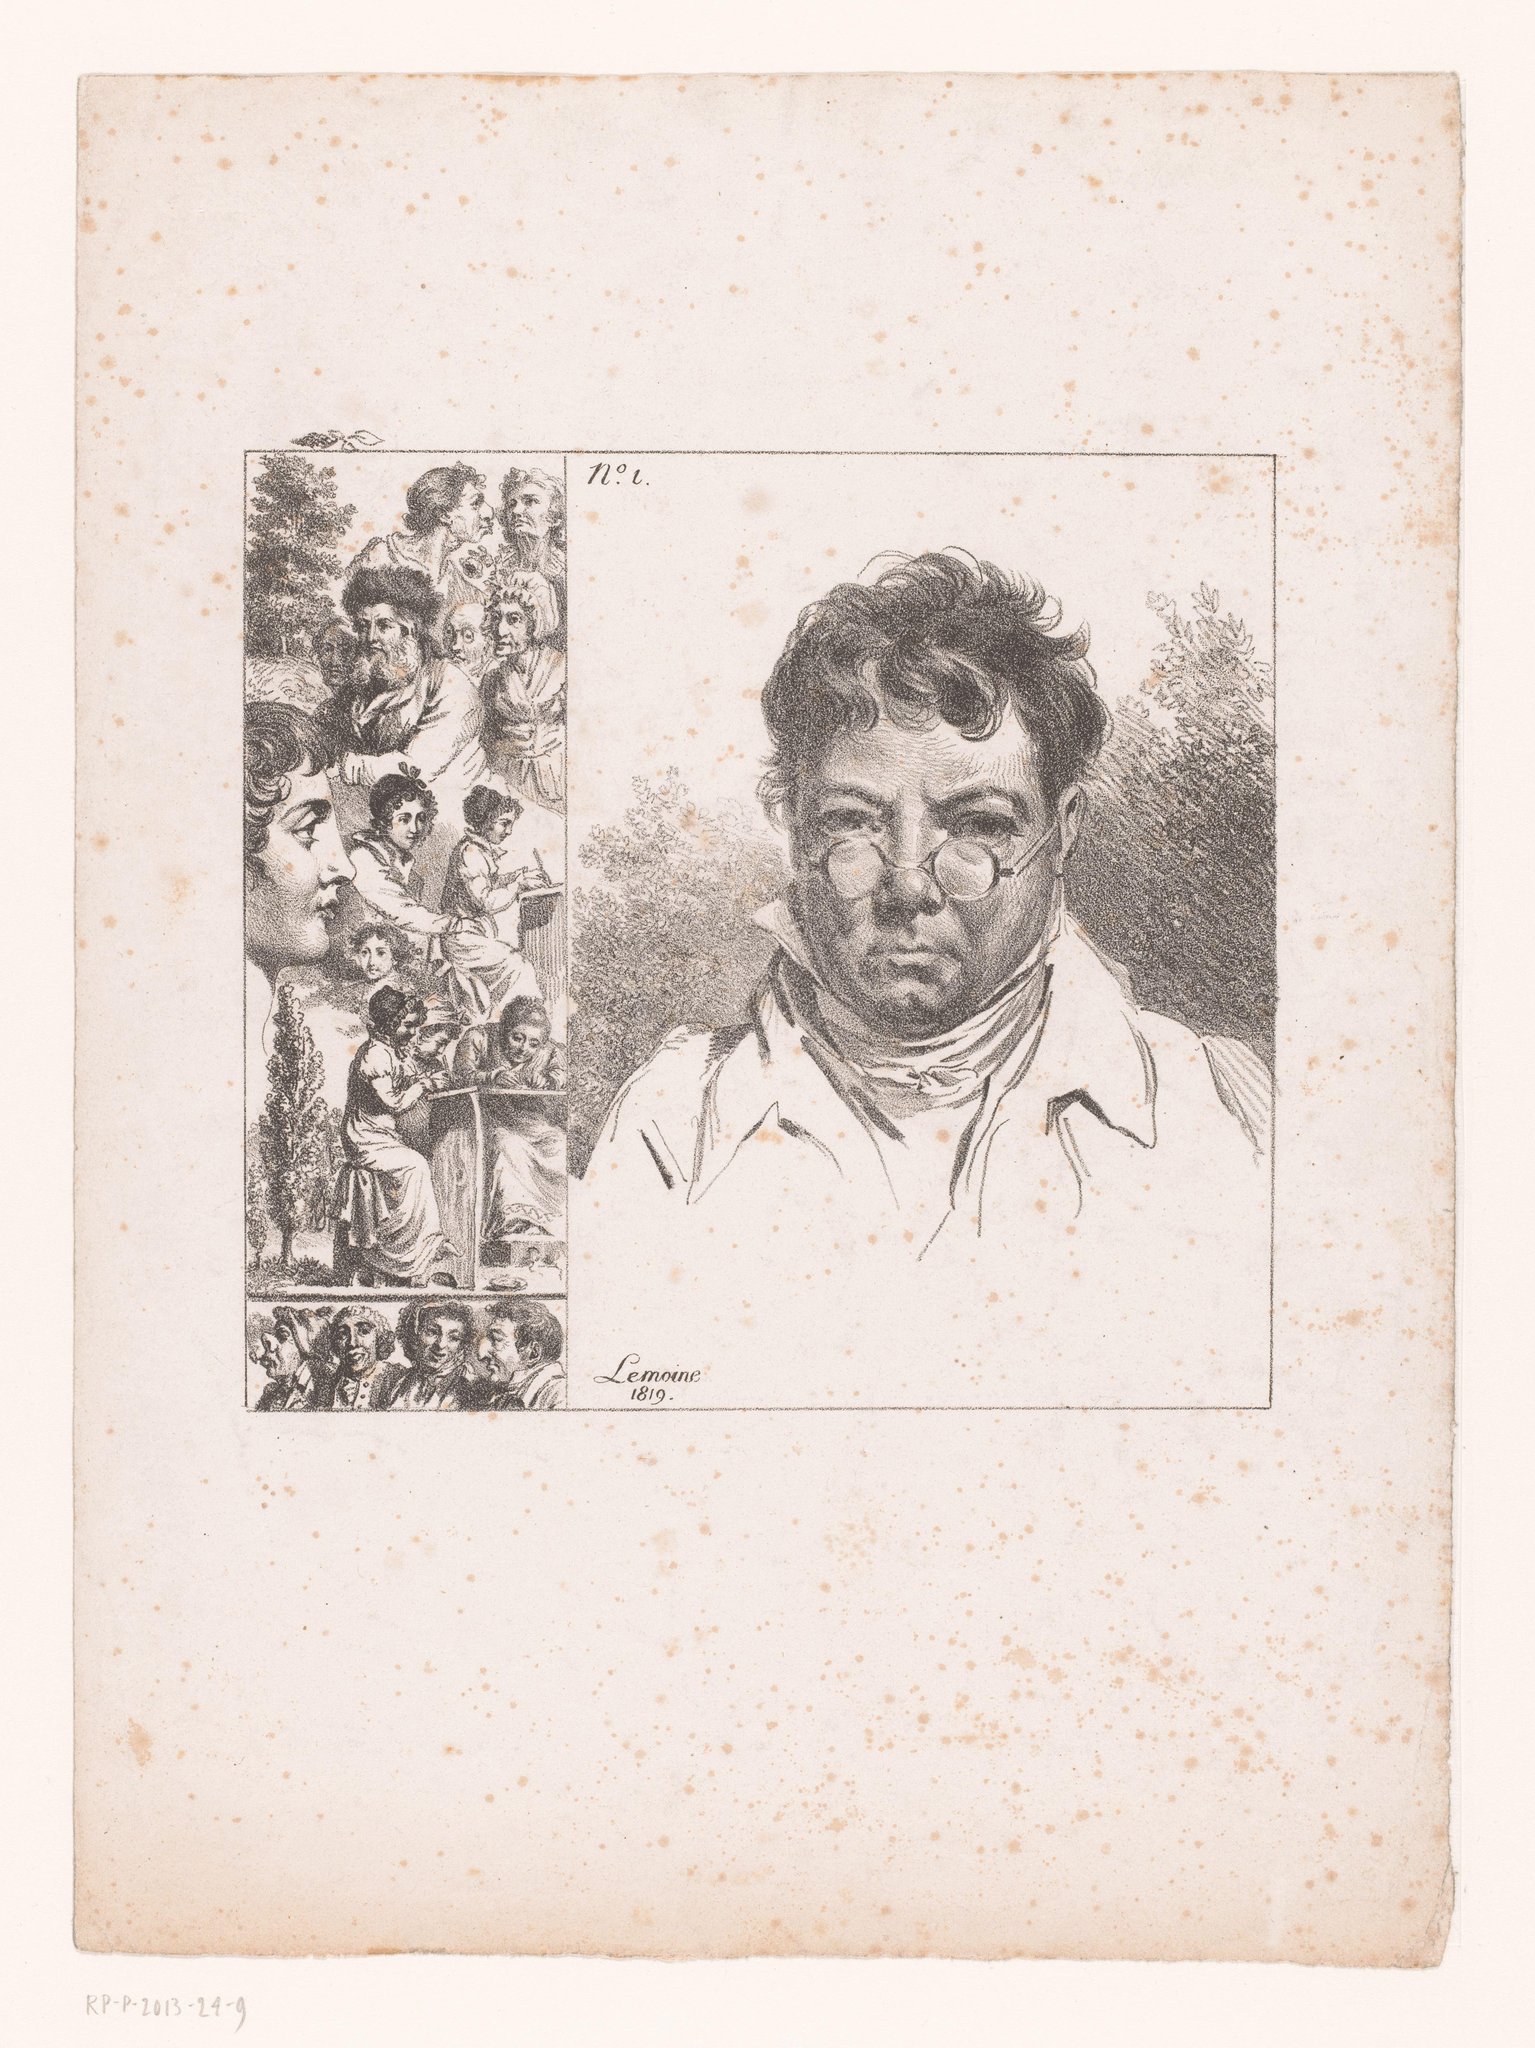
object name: print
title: Lemoine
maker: jacques antoine marie lemoine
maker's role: painter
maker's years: 1751-1824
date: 1819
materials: paper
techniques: lithograph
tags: paris, painter, jacques antoine marie lemoine, historical persons, portrait, self-portrait of graphic artist, portrait, self-portrait of draughtsman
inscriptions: date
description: Zelfportret met bril; in de linkerrand een aantal tekenstudies: koppen en figuren.